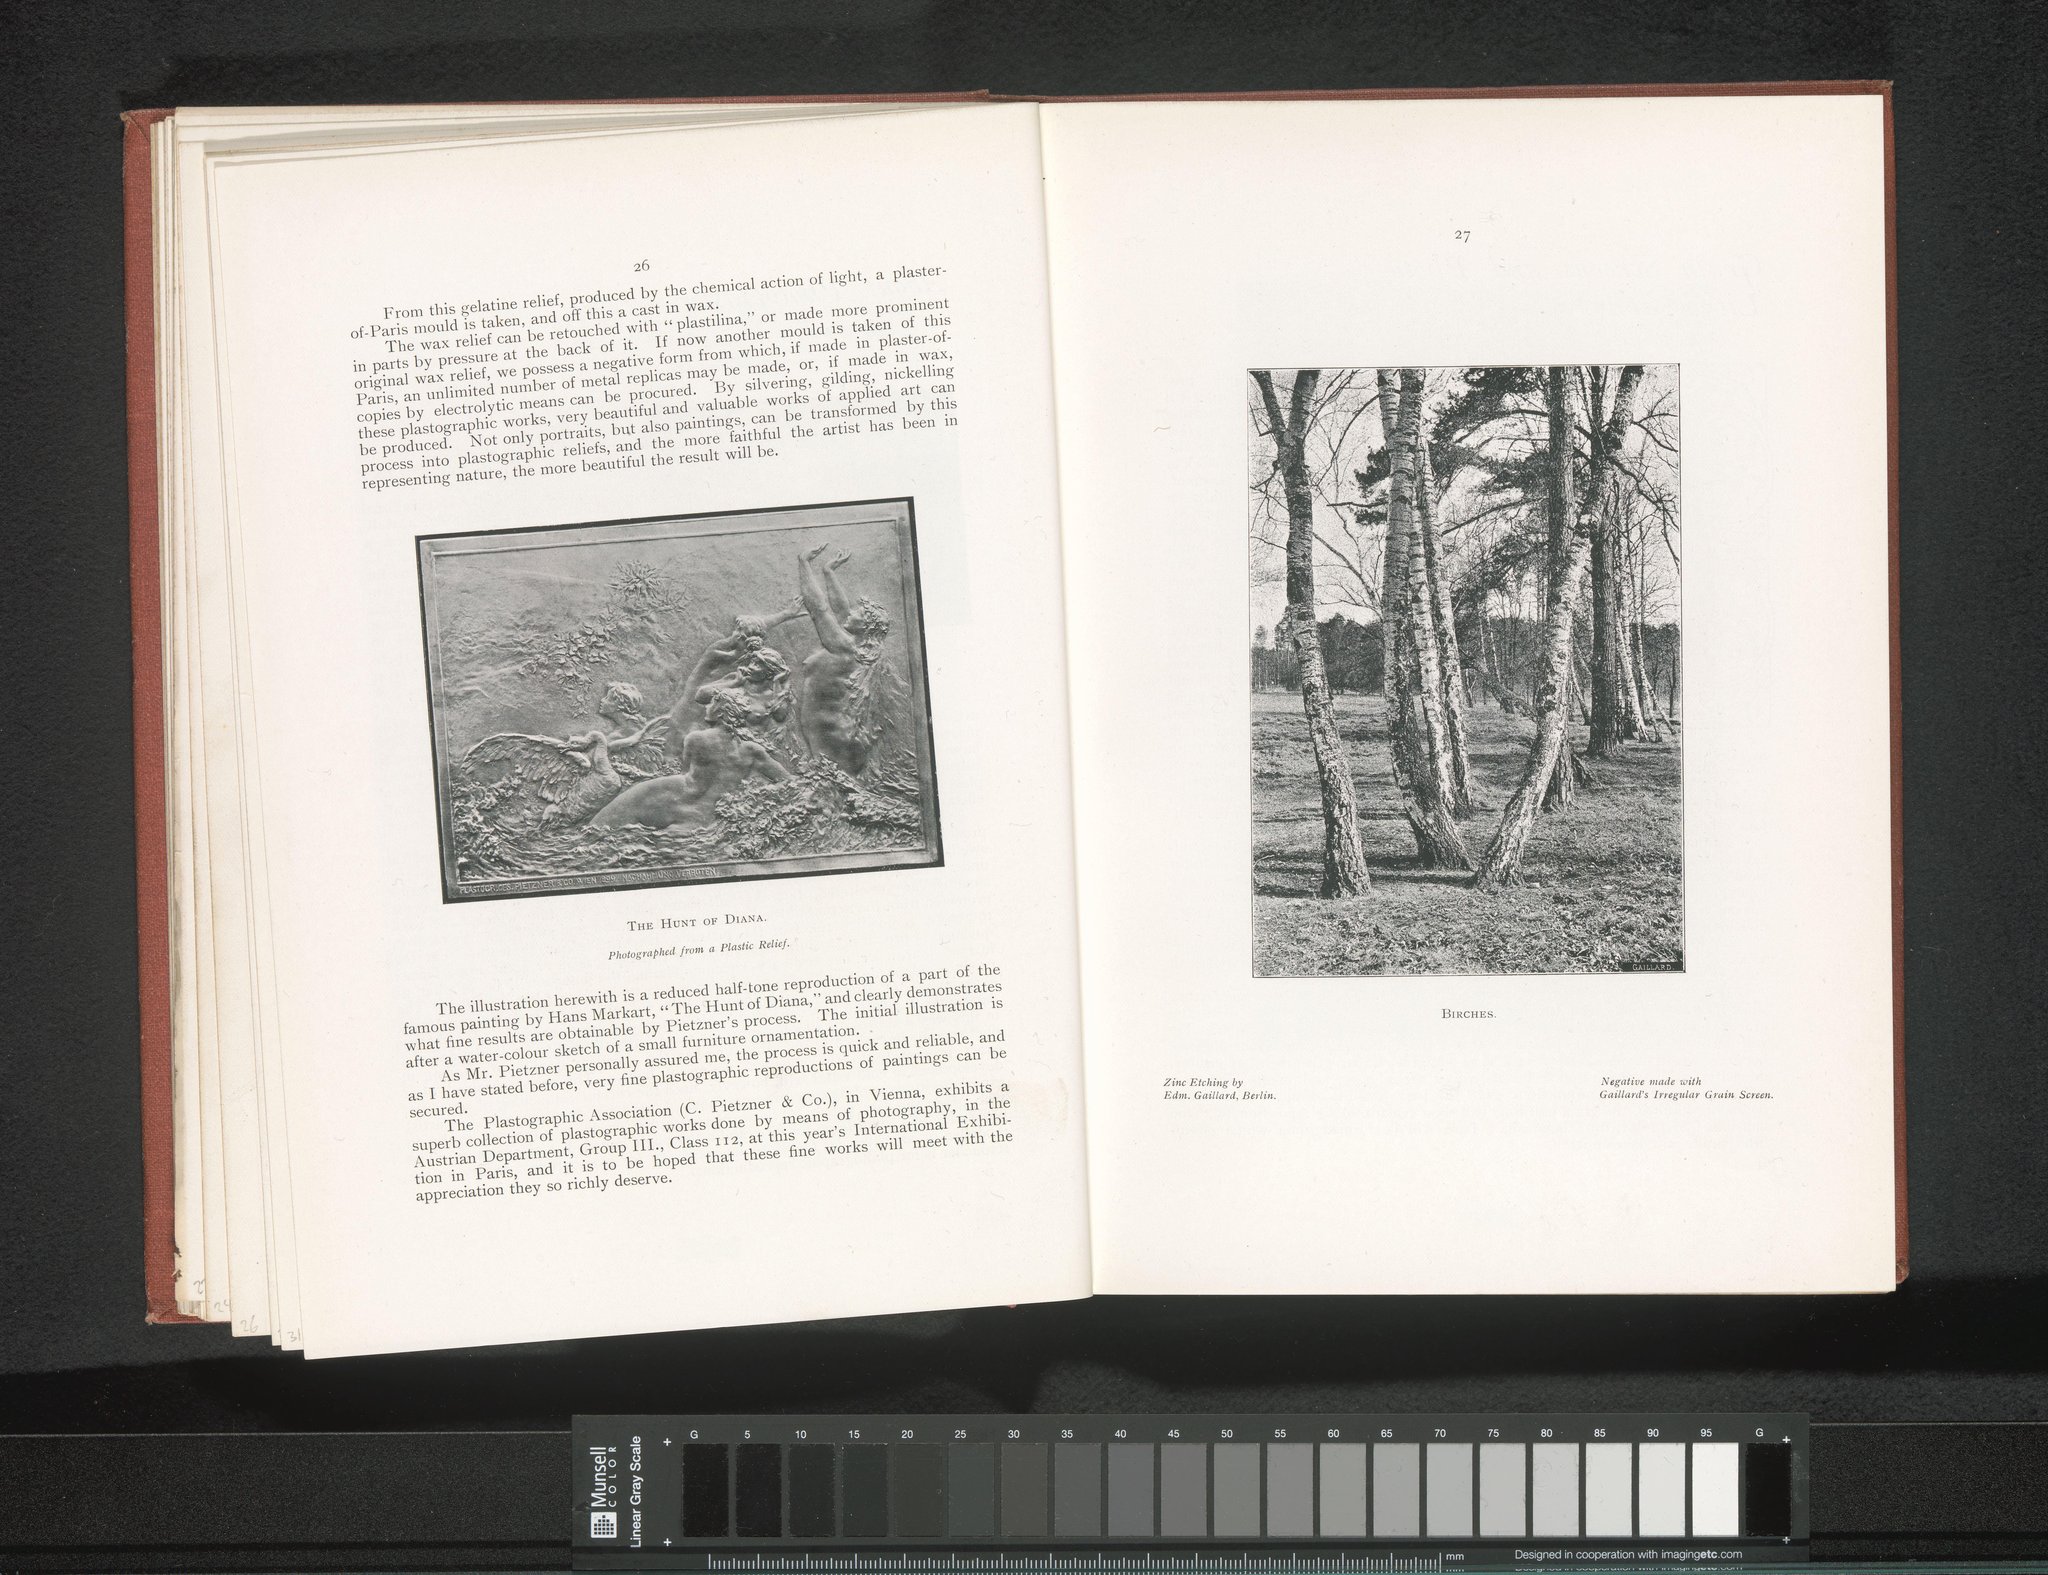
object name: page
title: Berken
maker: e. gaillard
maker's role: printer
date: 1895-1900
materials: paper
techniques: autotype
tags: trees: birch